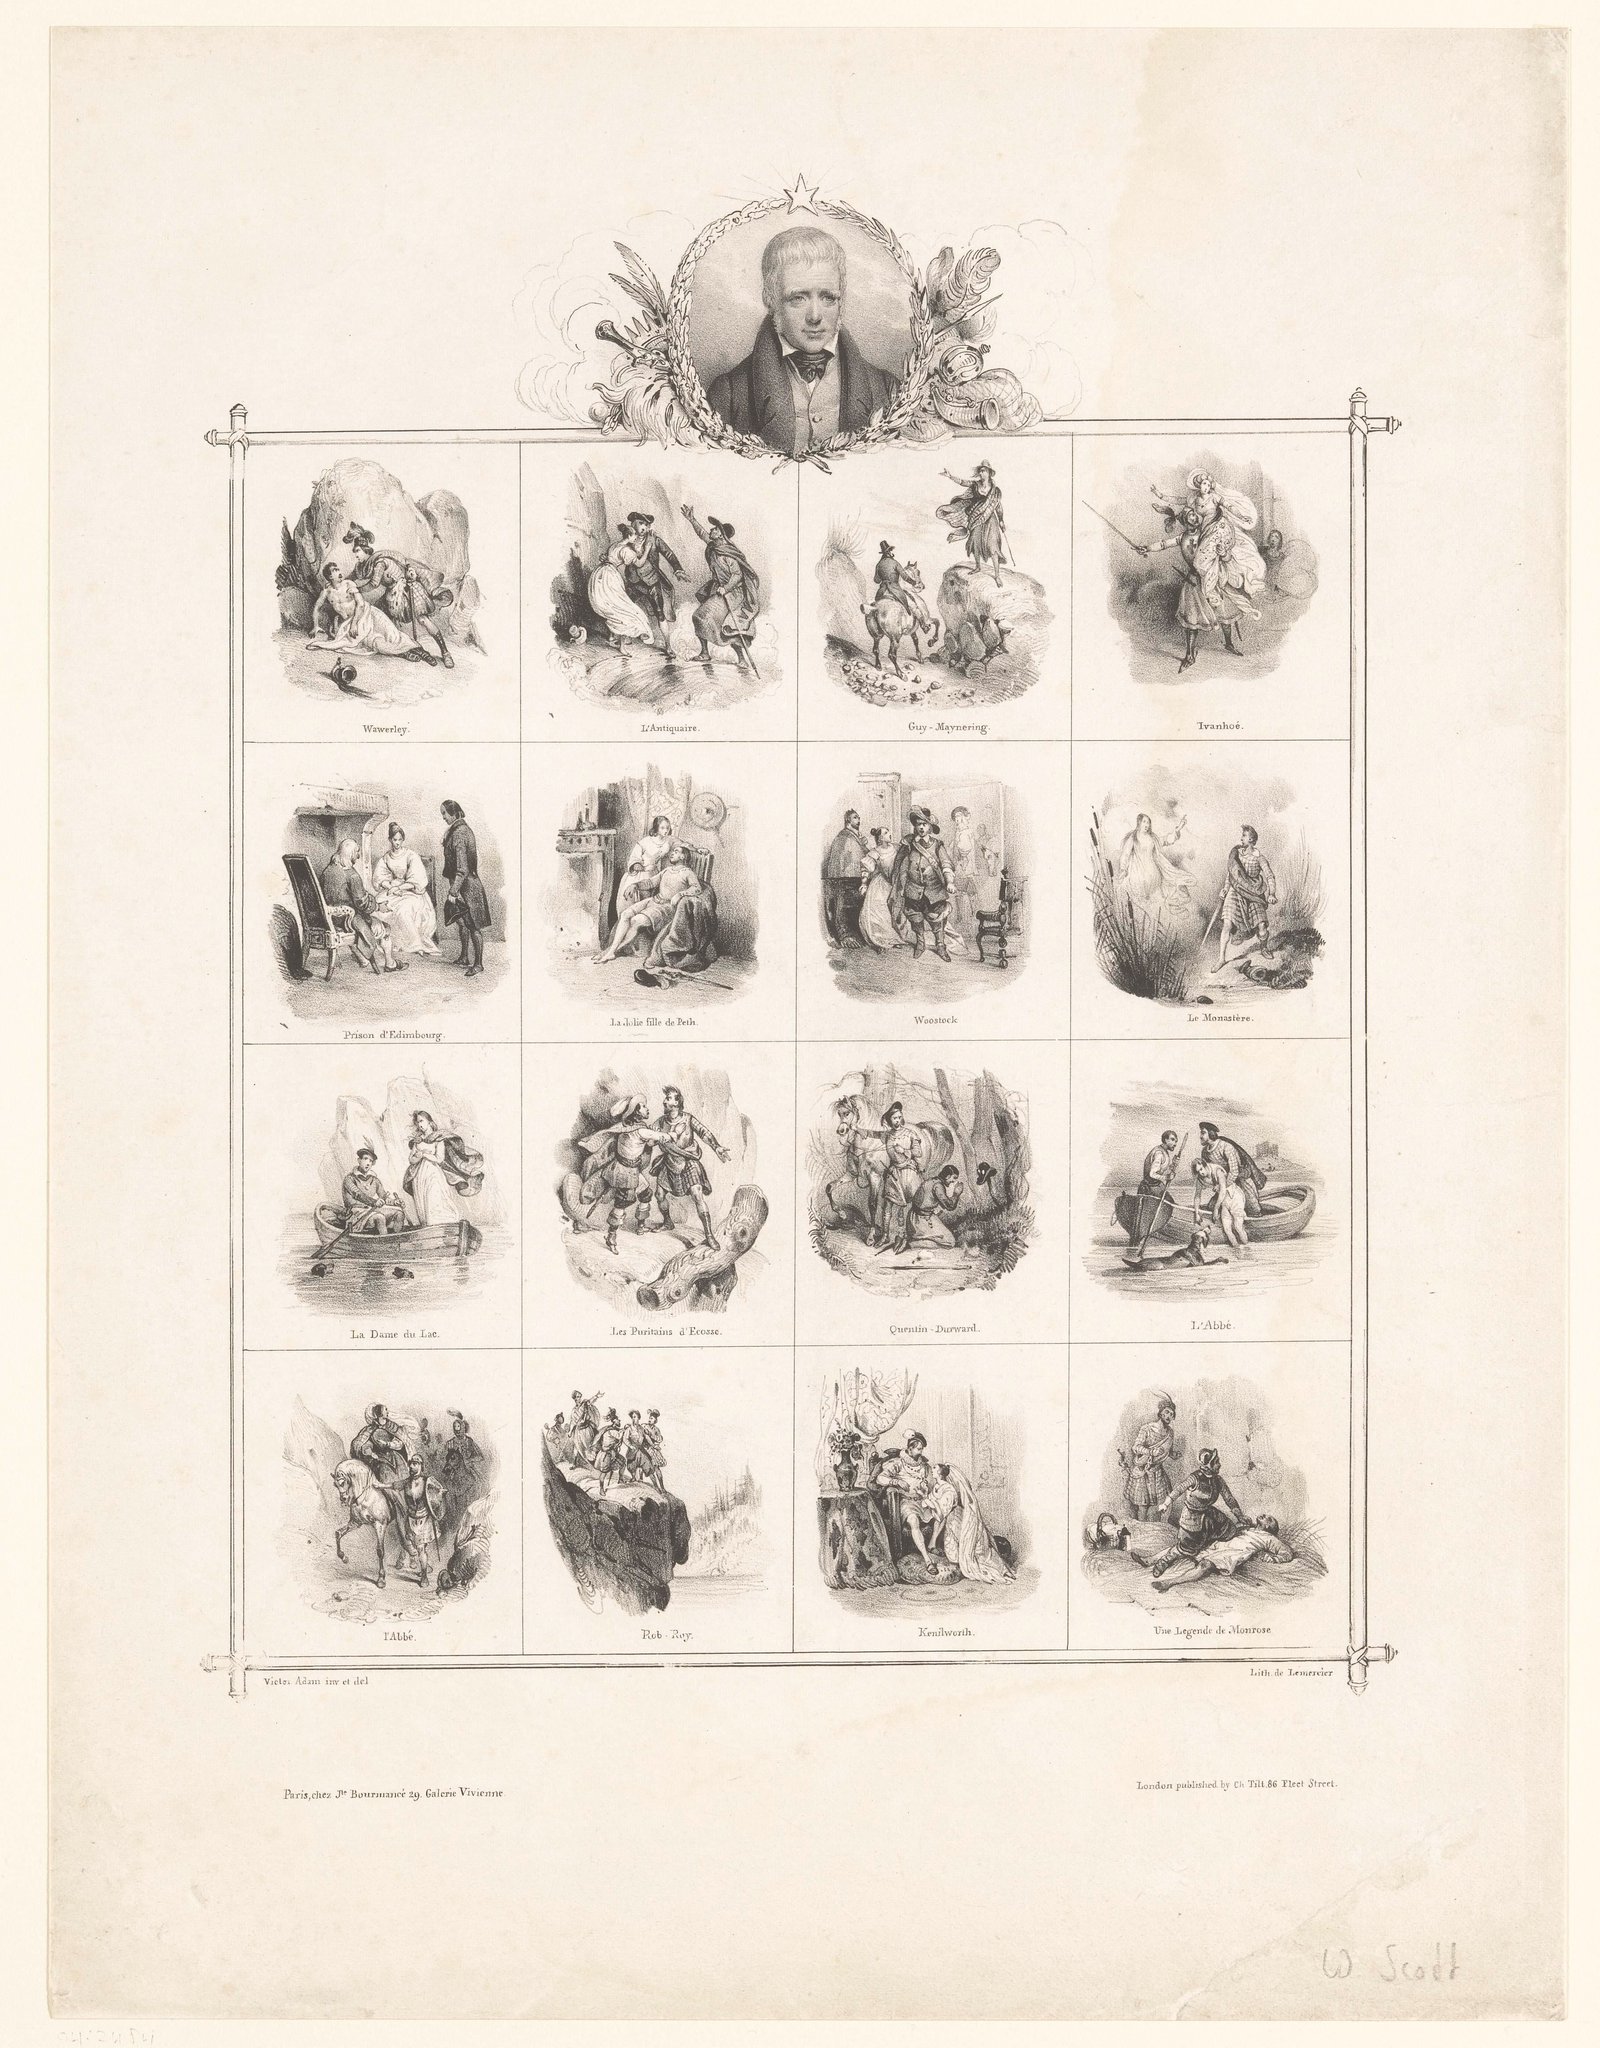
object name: print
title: Portraits d'écrivains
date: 1834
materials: paper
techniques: lithograph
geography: paris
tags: walter scott, historical persons, portrait of a writer, (scenes from) specific works of literature (with author, title)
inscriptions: collector's mark: Lugt 2228, annotation: ‘W. Scott’